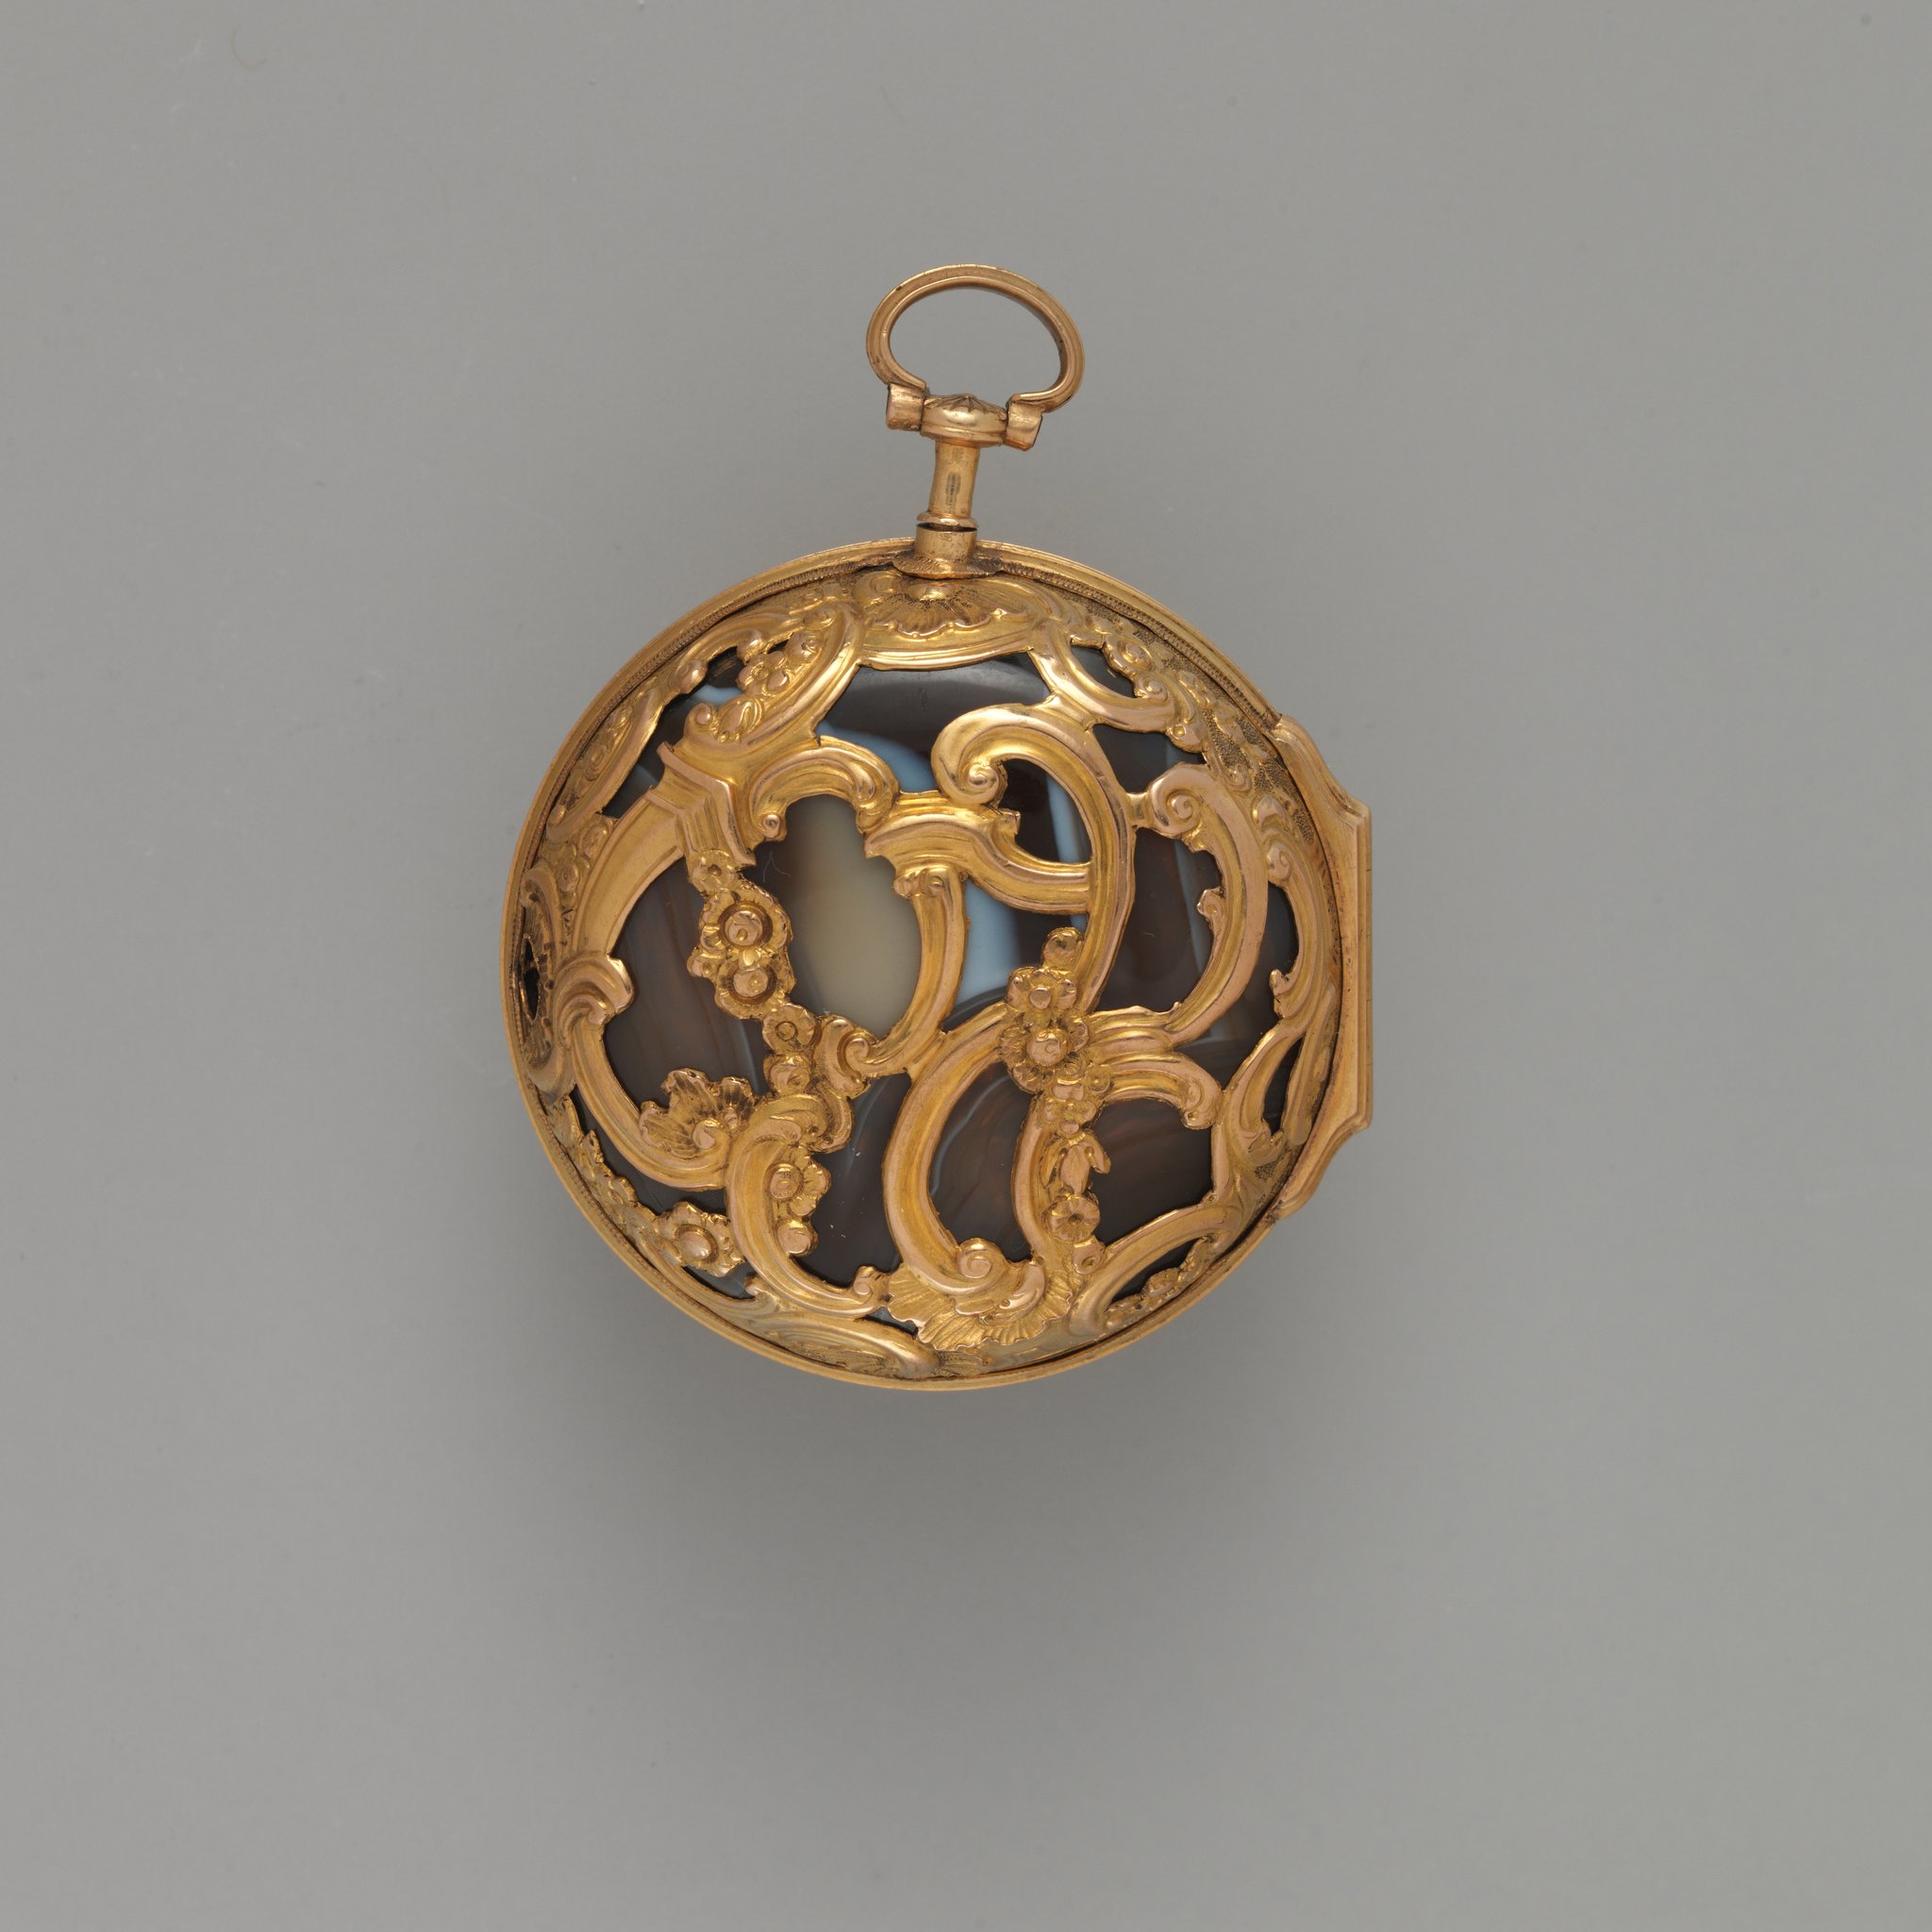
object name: watch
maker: rice (?) williamson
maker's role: maker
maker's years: 1735-1745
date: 1740-1750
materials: stone, enamel, gold